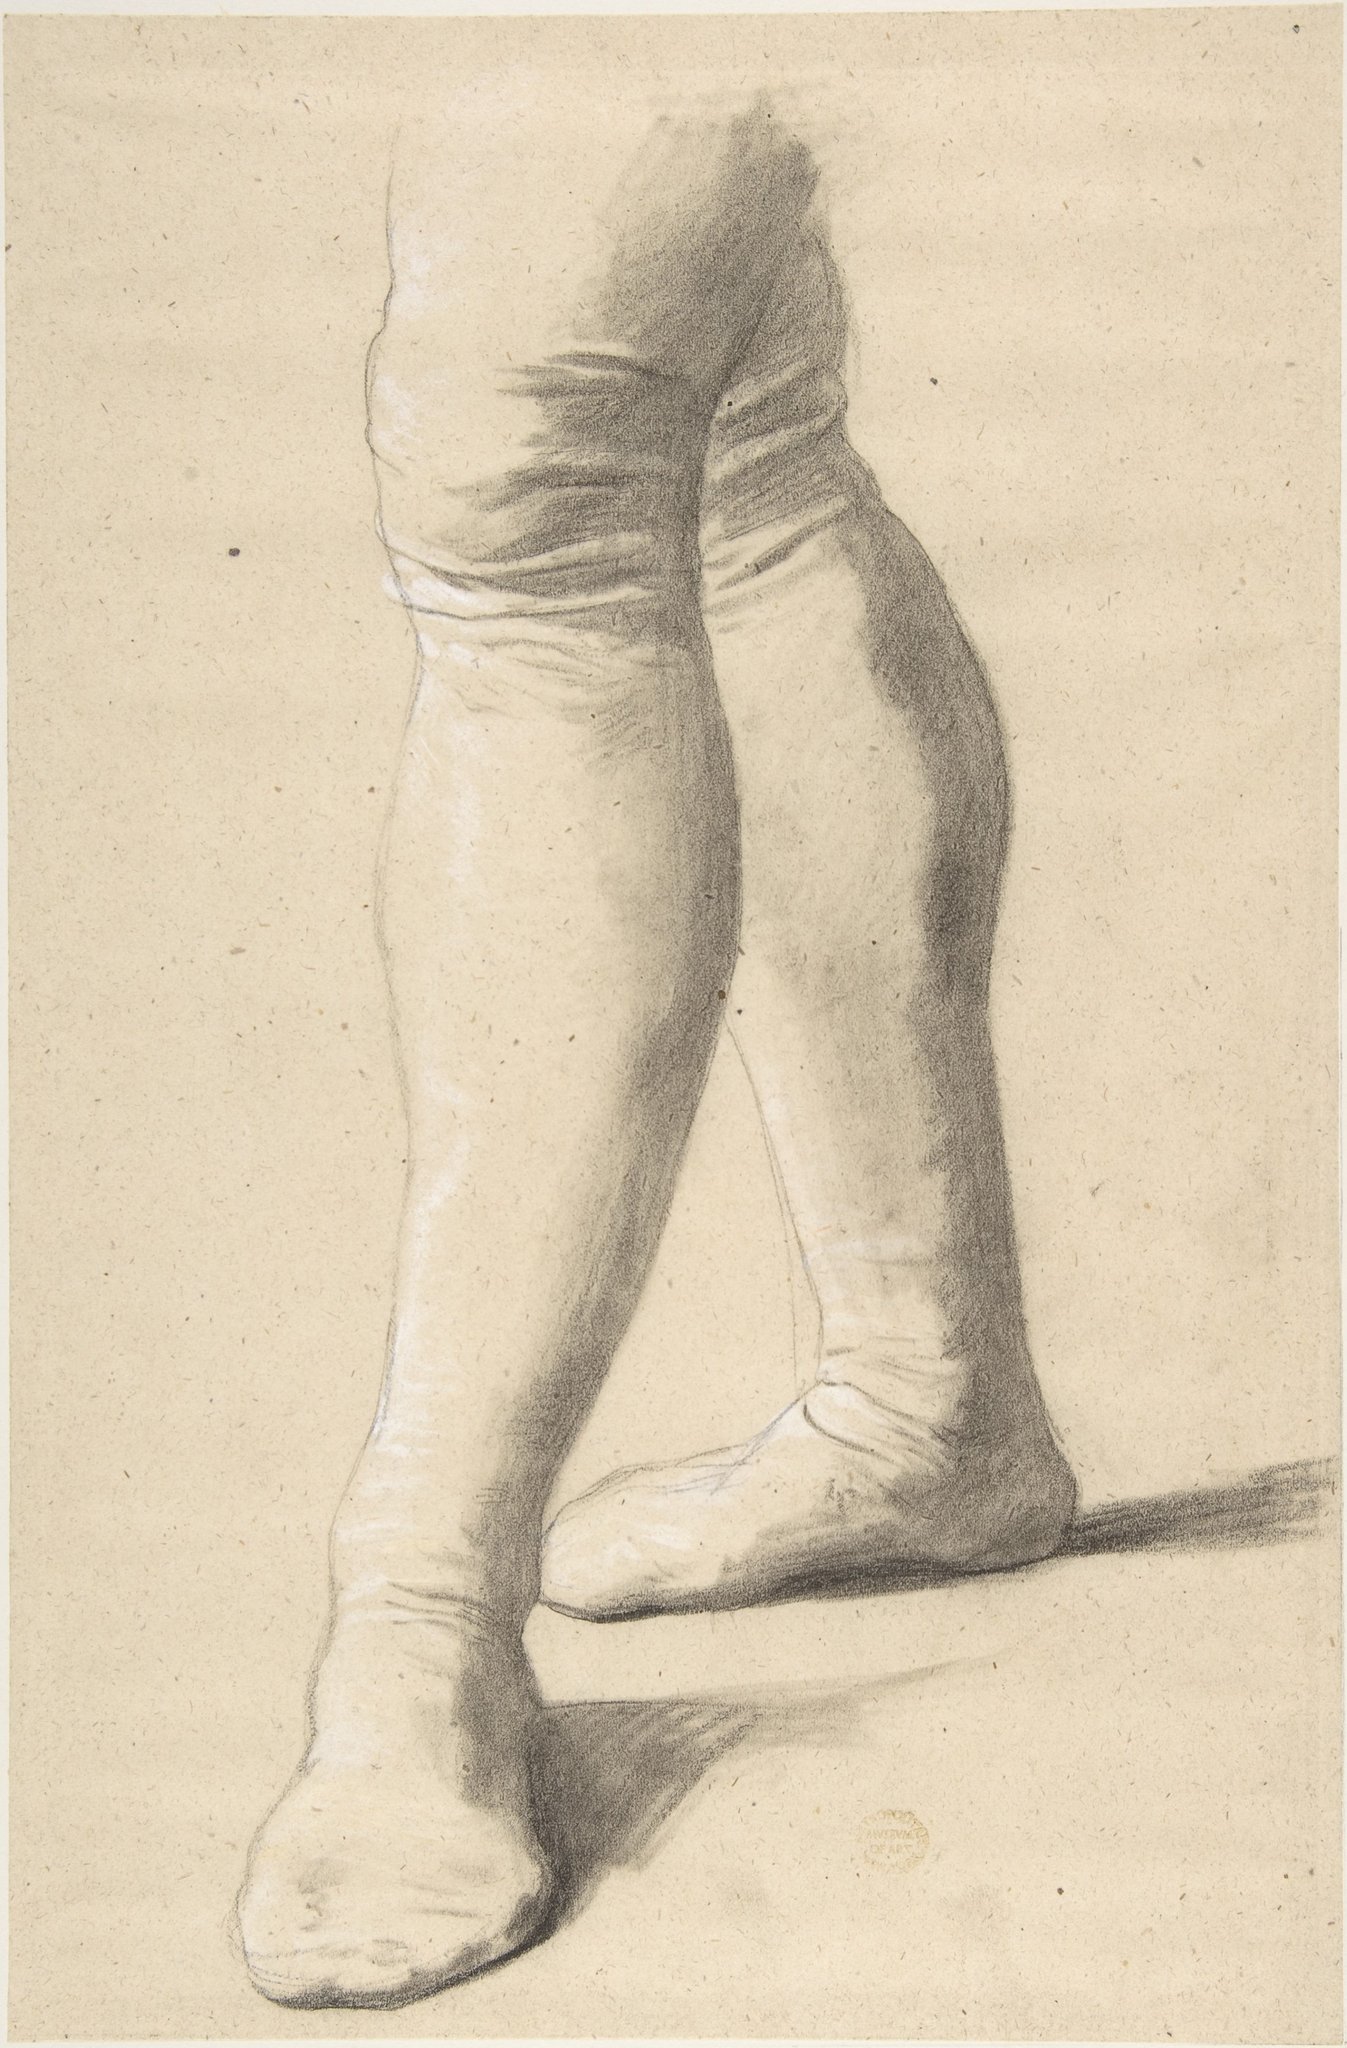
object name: drawing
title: Study of Legs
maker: romain cazes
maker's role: artist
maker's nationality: french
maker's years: 1808-1881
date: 1828-1881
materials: chalk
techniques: highlighting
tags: feet